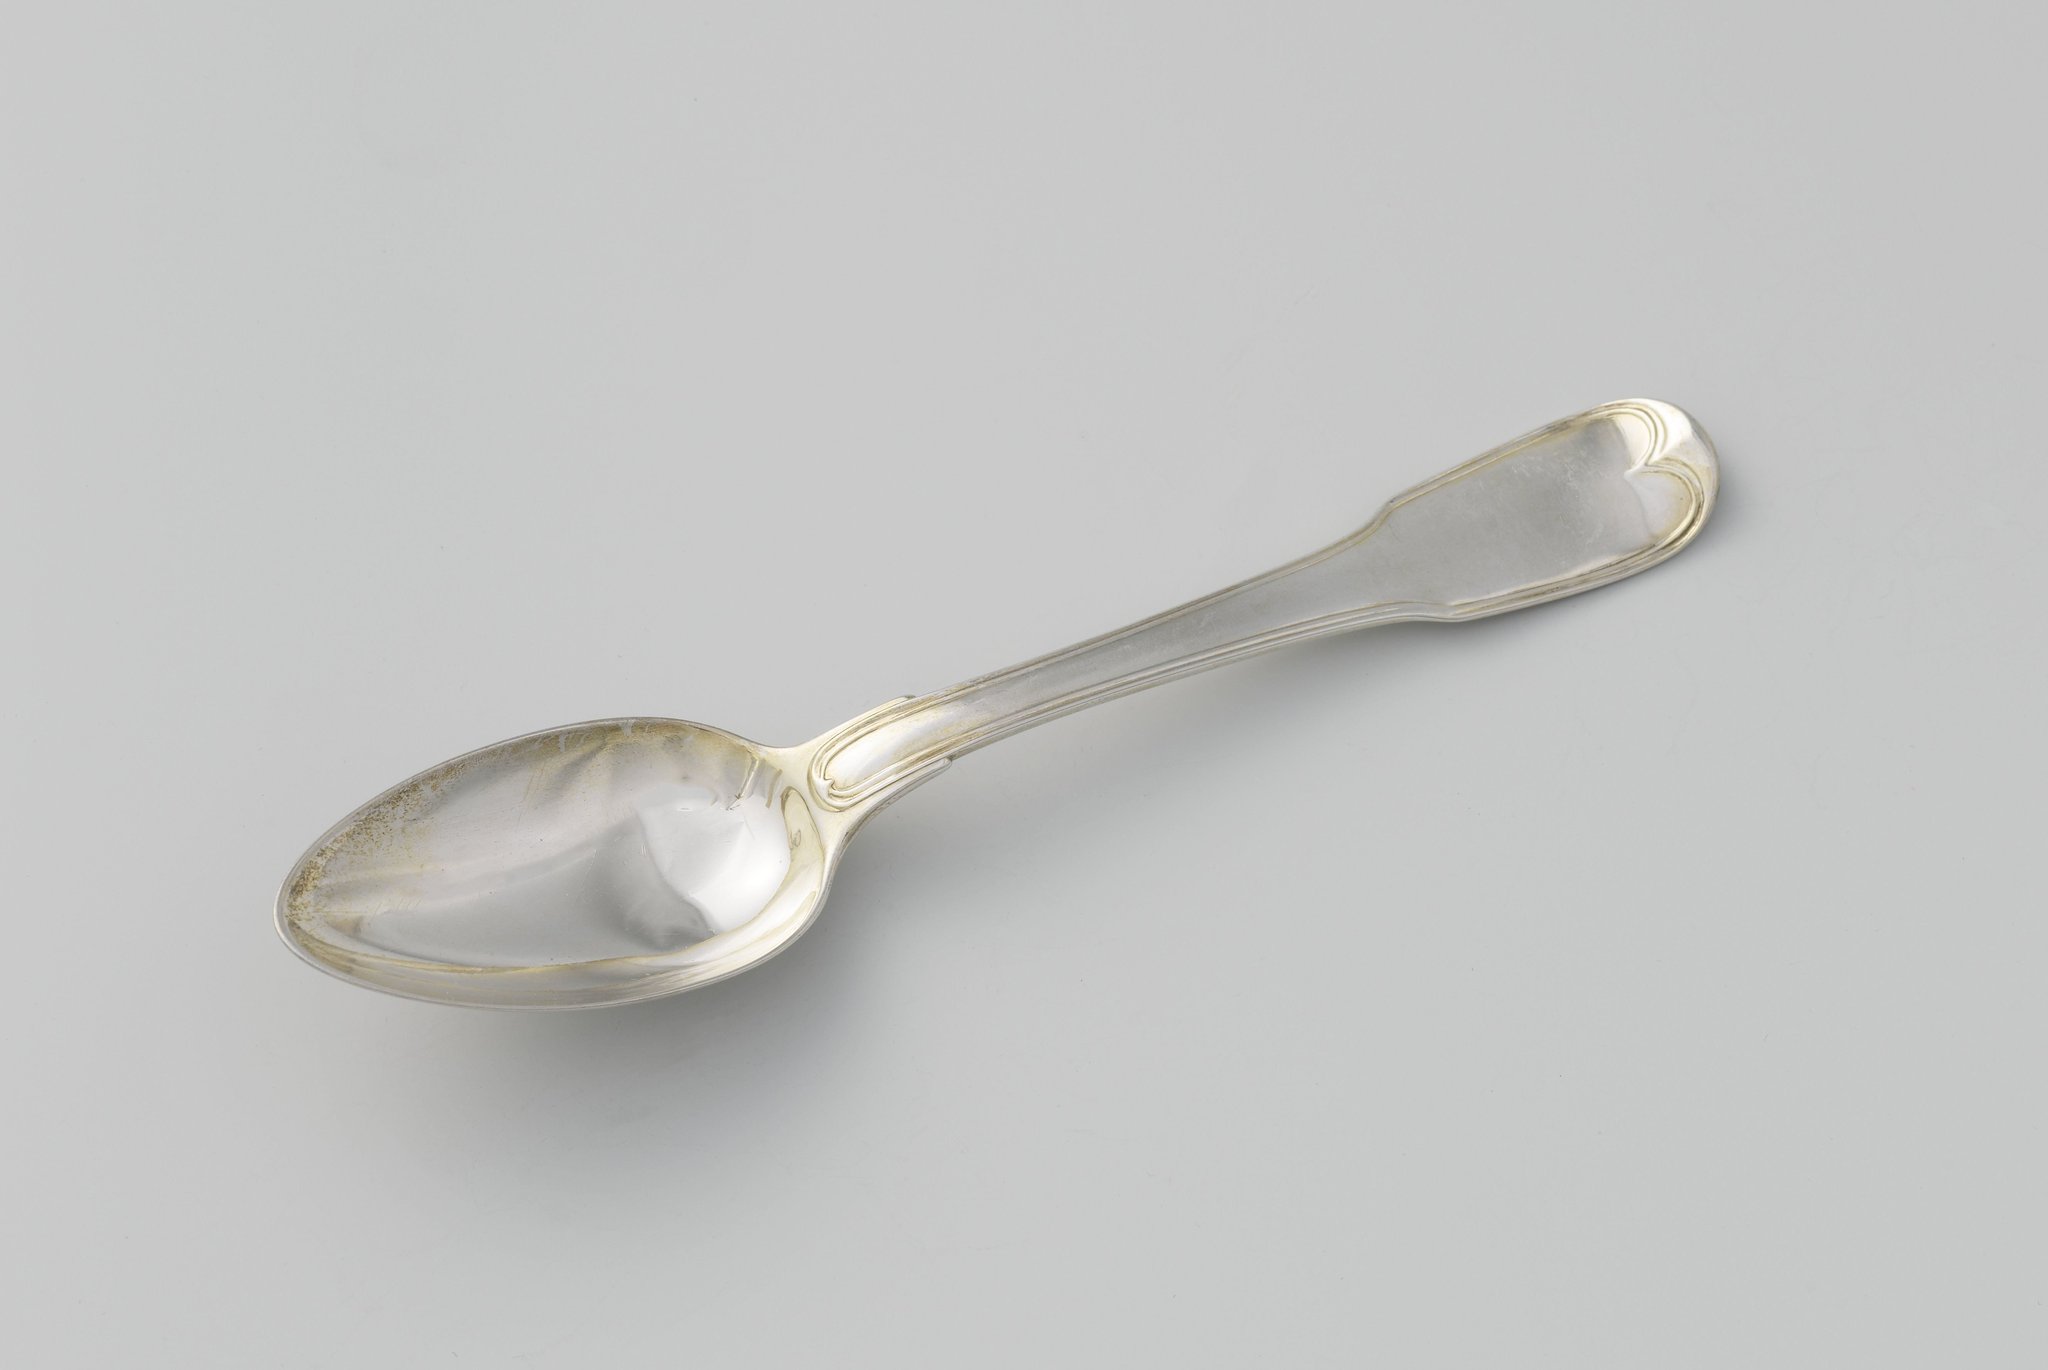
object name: spoon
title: Lepel met het helmteken Clifford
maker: roelof helweg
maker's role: silversmith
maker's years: 1758-1843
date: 1806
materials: silver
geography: amsterdam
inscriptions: town mark: ‘Amsterdam’, maker's mark: ‘RH in ovaal’, date letter: ‘X (=1806)’, alloy mark: ‘Hollandse leeuw’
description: De eivormige bak van de lepel is aan zowel boven- als onderzijde door middel van enkel lof verbonden met de platte, gebogen steel, die zich verbreedt naar het spatelvormige uiteinde. Boven- en onderzijde van de steel worden omgeven door een dubbele filetrand, die bij het uiteinde ingezwenkt is. Op de onderzijde van de spatel is het helmteken Clifford gegraveerd.